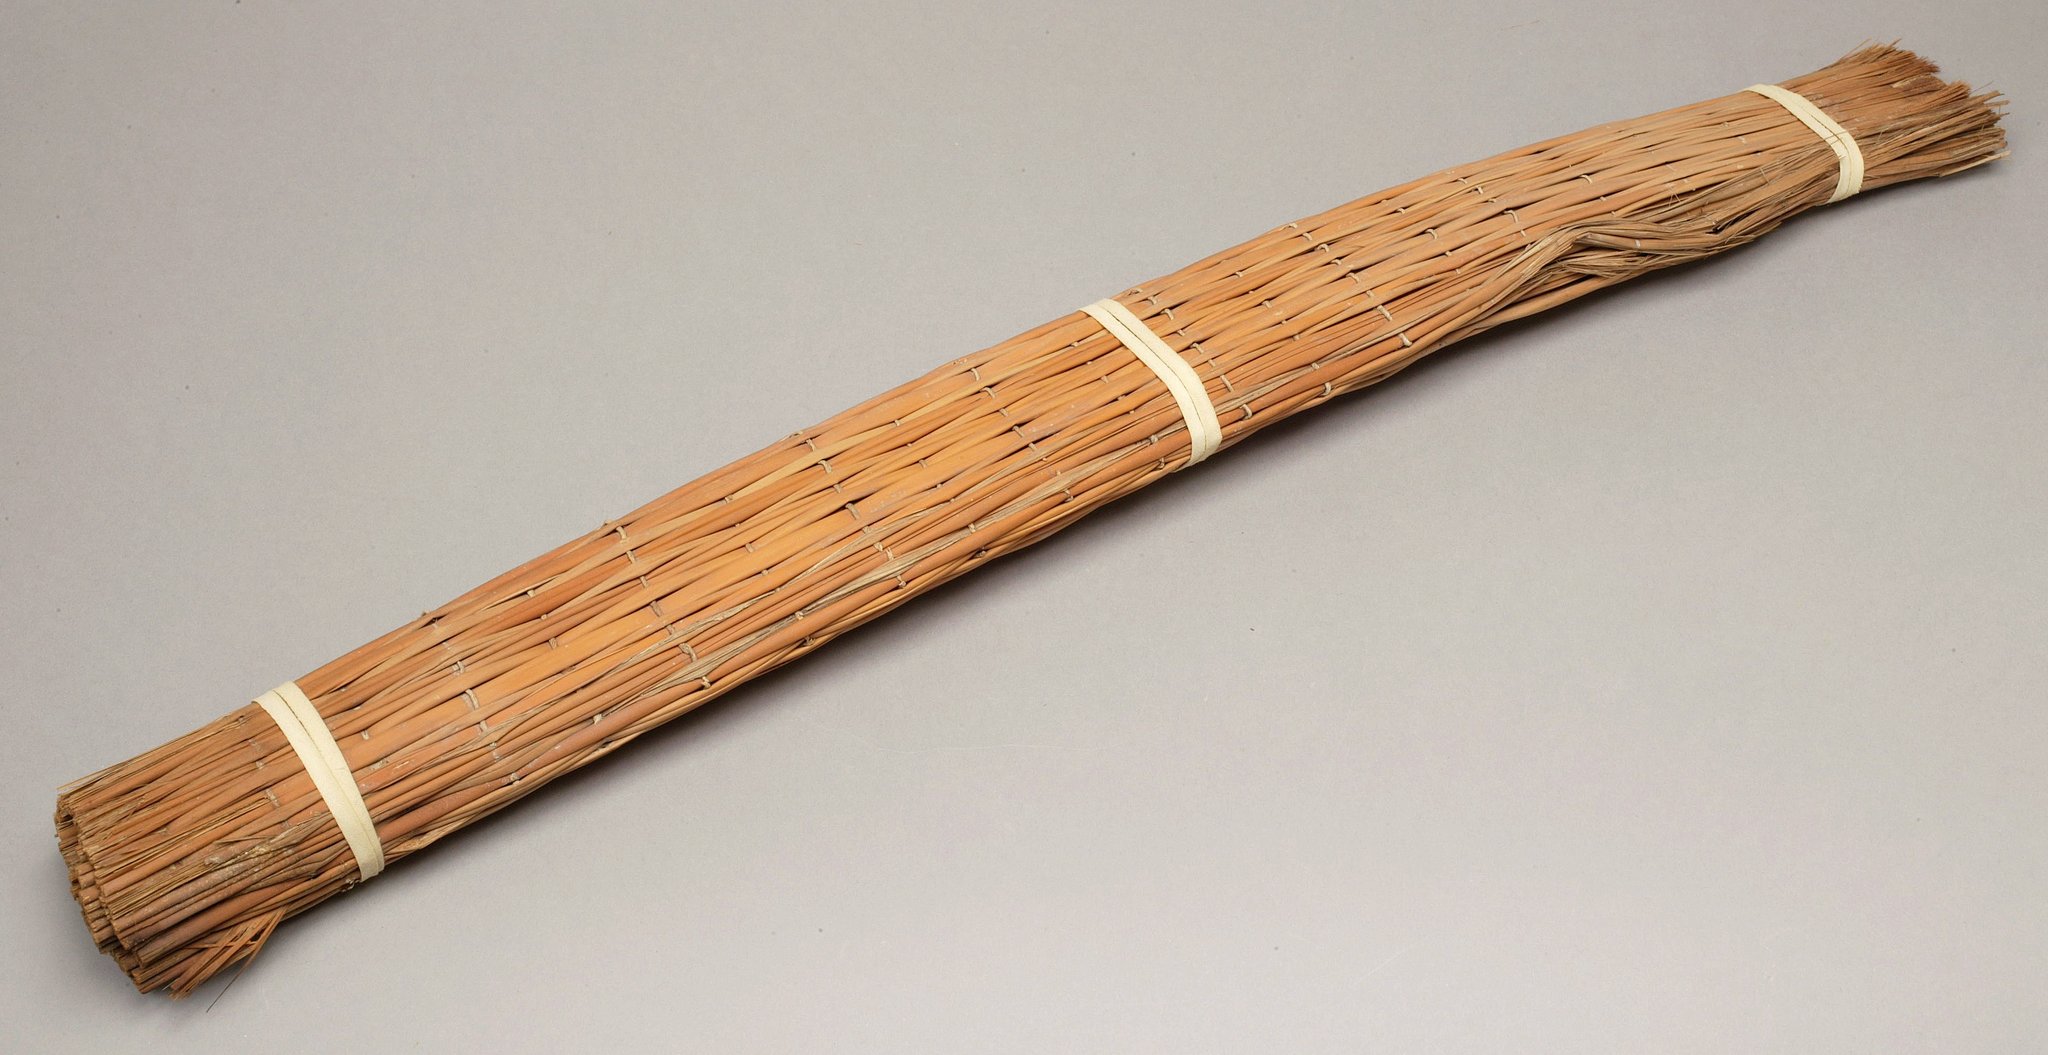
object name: mat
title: Mat From Foundation Deposit C, Hatshepsut's Temple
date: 1479-1458 BCE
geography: egypt